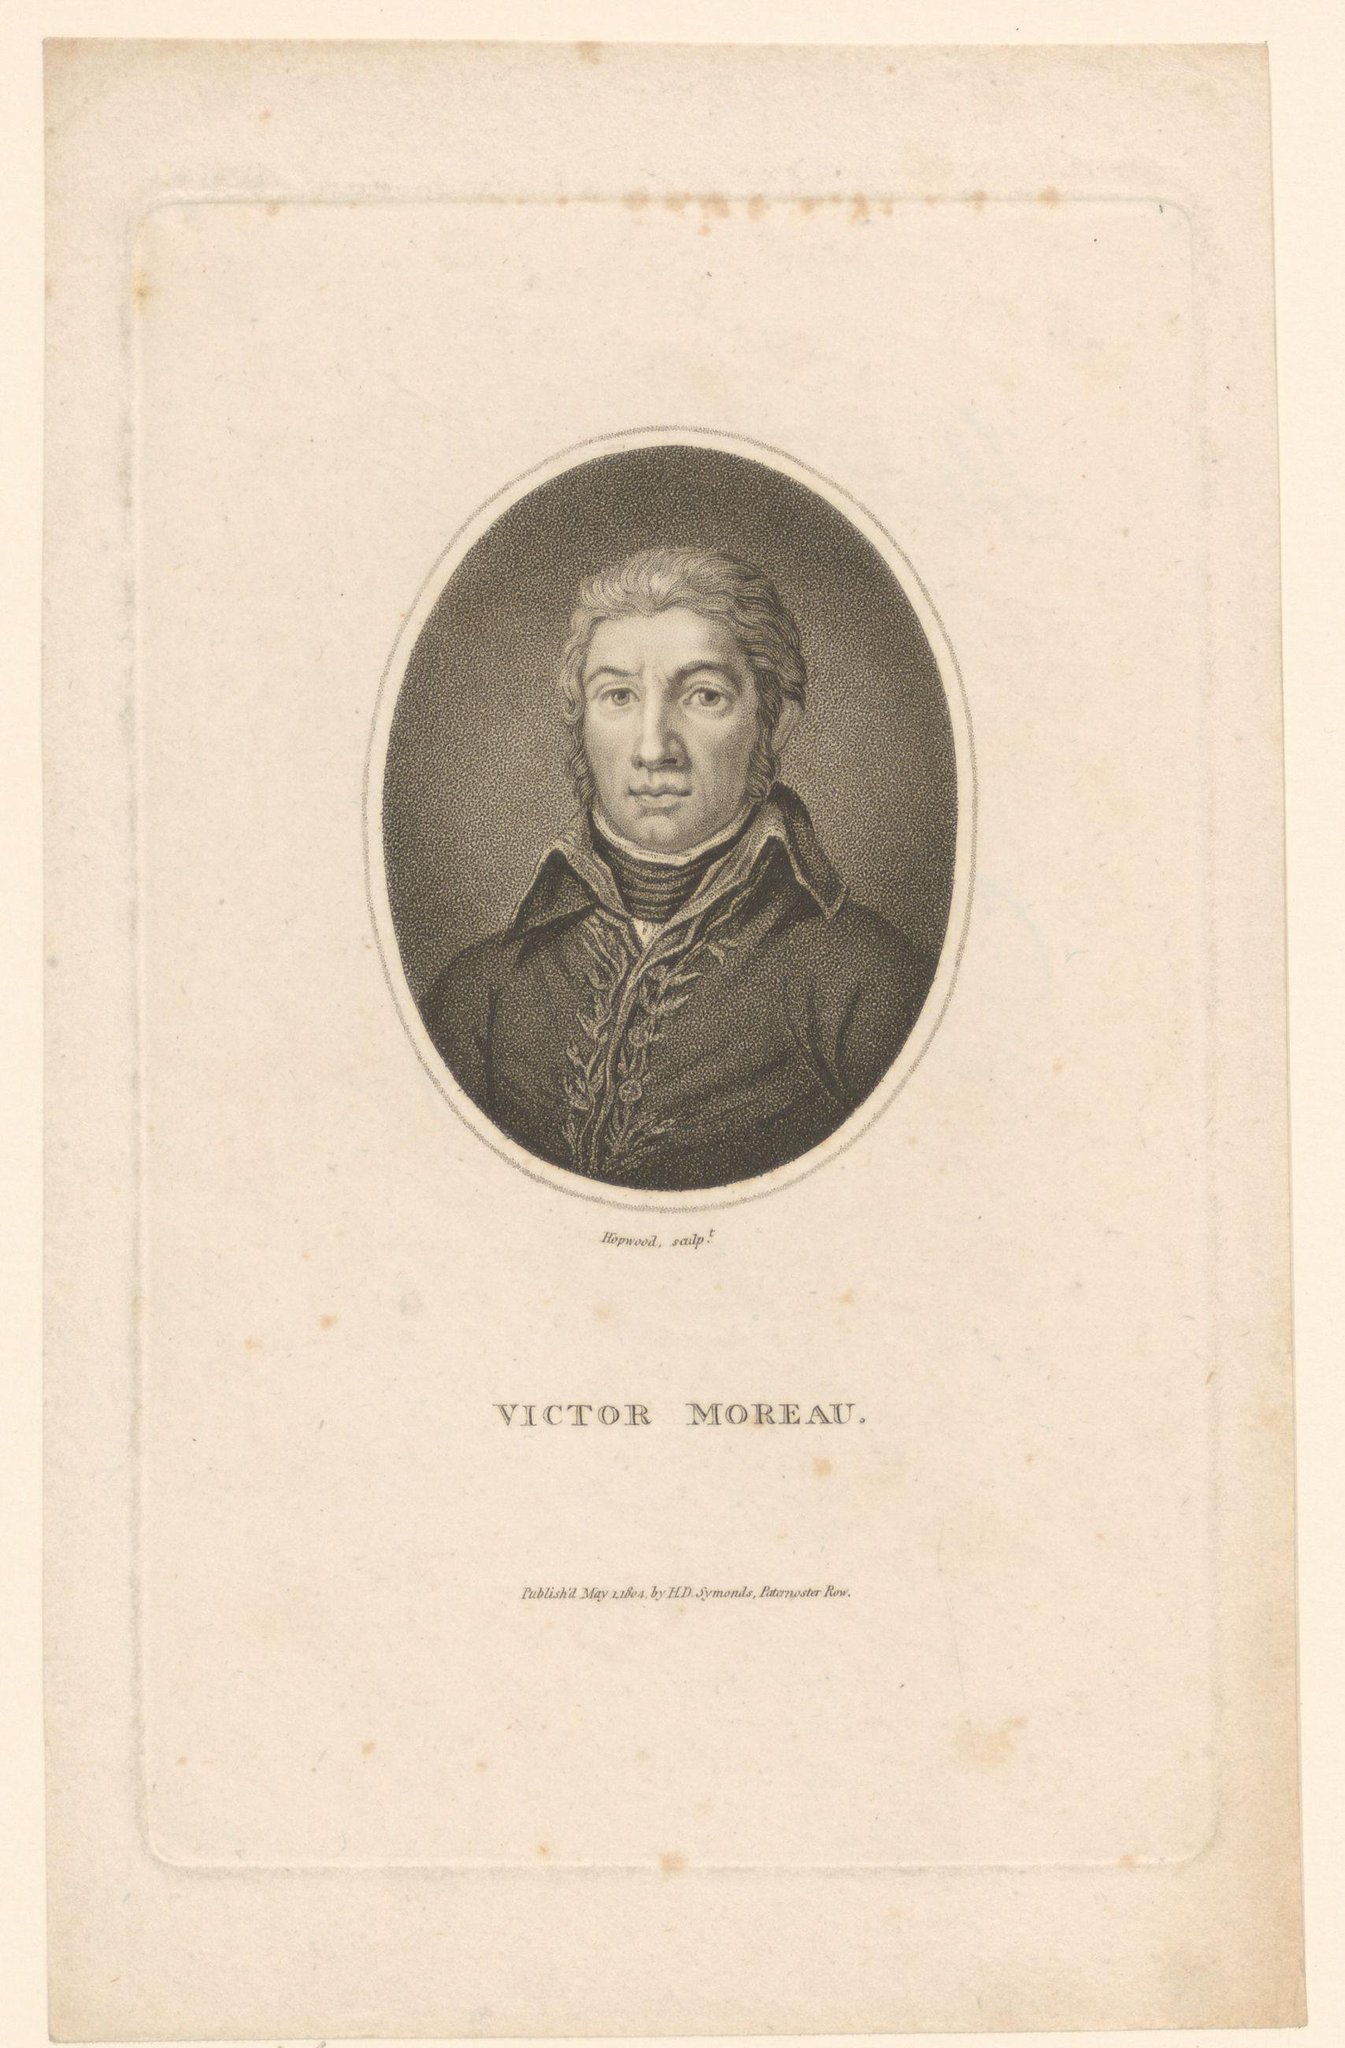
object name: print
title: Portret van Jean Victor Marie Moreau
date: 1804-1805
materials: paper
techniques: etching, engraving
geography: england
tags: commander-in-chief, general, marshal, historical persons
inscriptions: collector's mark: Lugt 2228